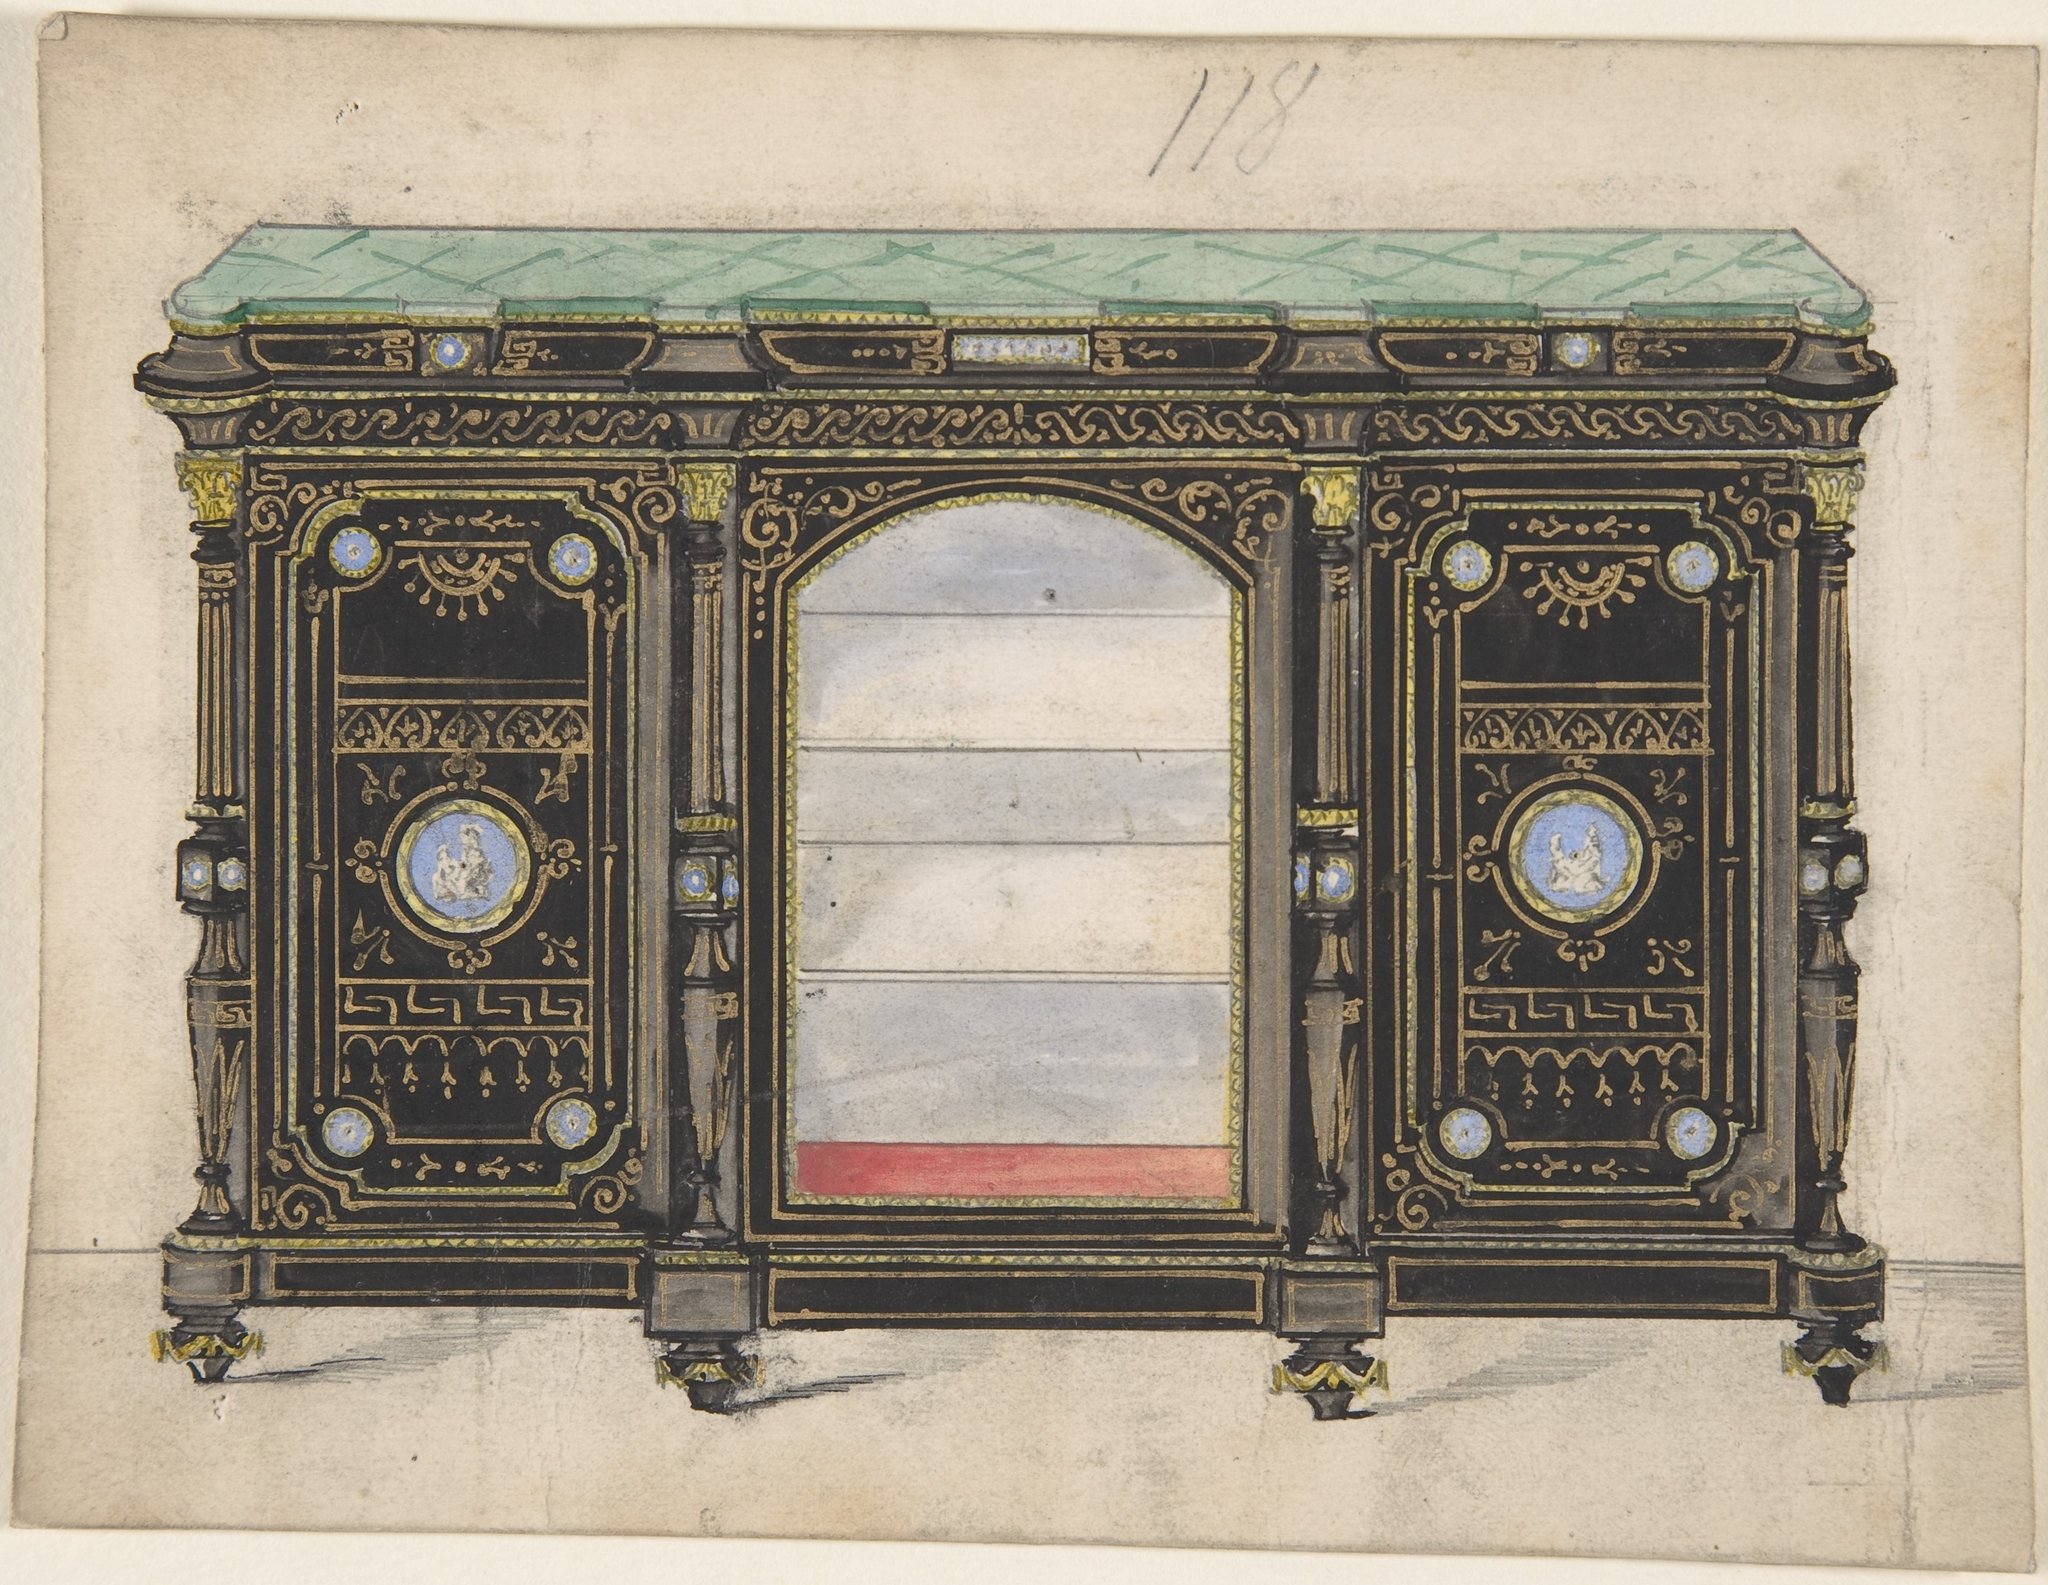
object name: drawing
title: Cabinet Design with Glass Front, its Doors Adorned with Porcelain Plaques, with a Green Top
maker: anonymous, british, 19th century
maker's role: artist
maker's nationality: british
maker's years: 1800-1900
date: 1801-1900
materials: ink, watercolor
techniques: pen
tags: cabinets